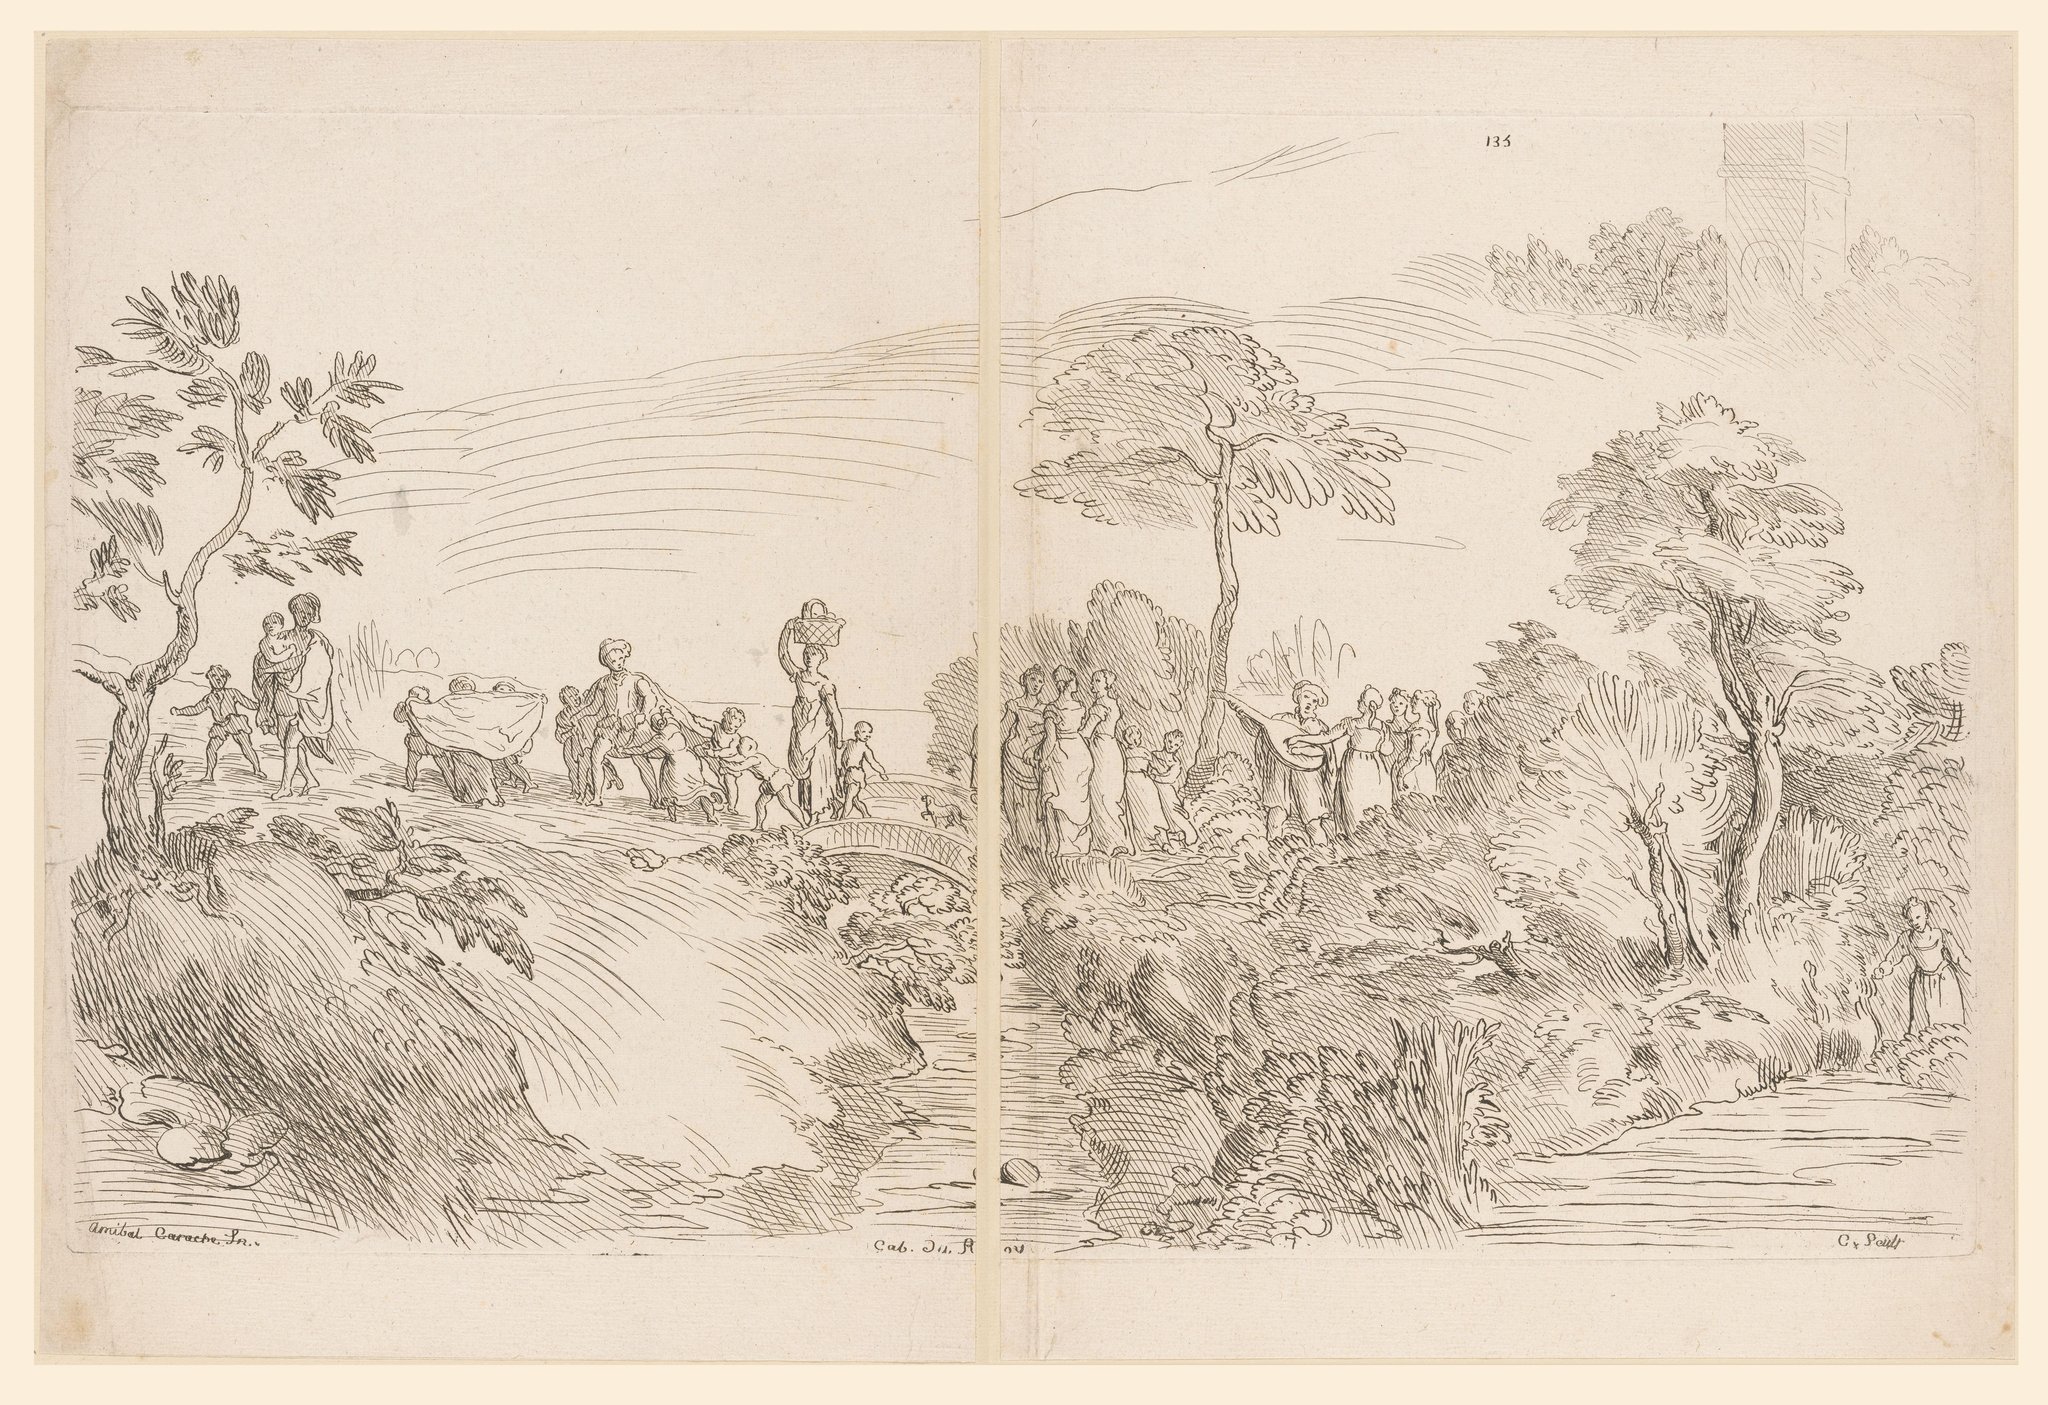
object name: print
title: Optocht in een landschap met een brug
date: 1702-1765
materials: paper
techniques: etching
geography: france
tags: landscapes in the temperate zone - hh - ideal landscapes, bridge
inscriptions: collector's mark: Lugt 240, collector's mark: Lugt 2228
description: Dit object is omwille van een betere presentatie virtueel samengevoegd maar bestaat fysiek uit losse onderdelen. Maakt deel uit van een serie getiteld: "Cabinet du Roy" van 222 etsen naar tekeningen uit de Franse koninklijke collectie.